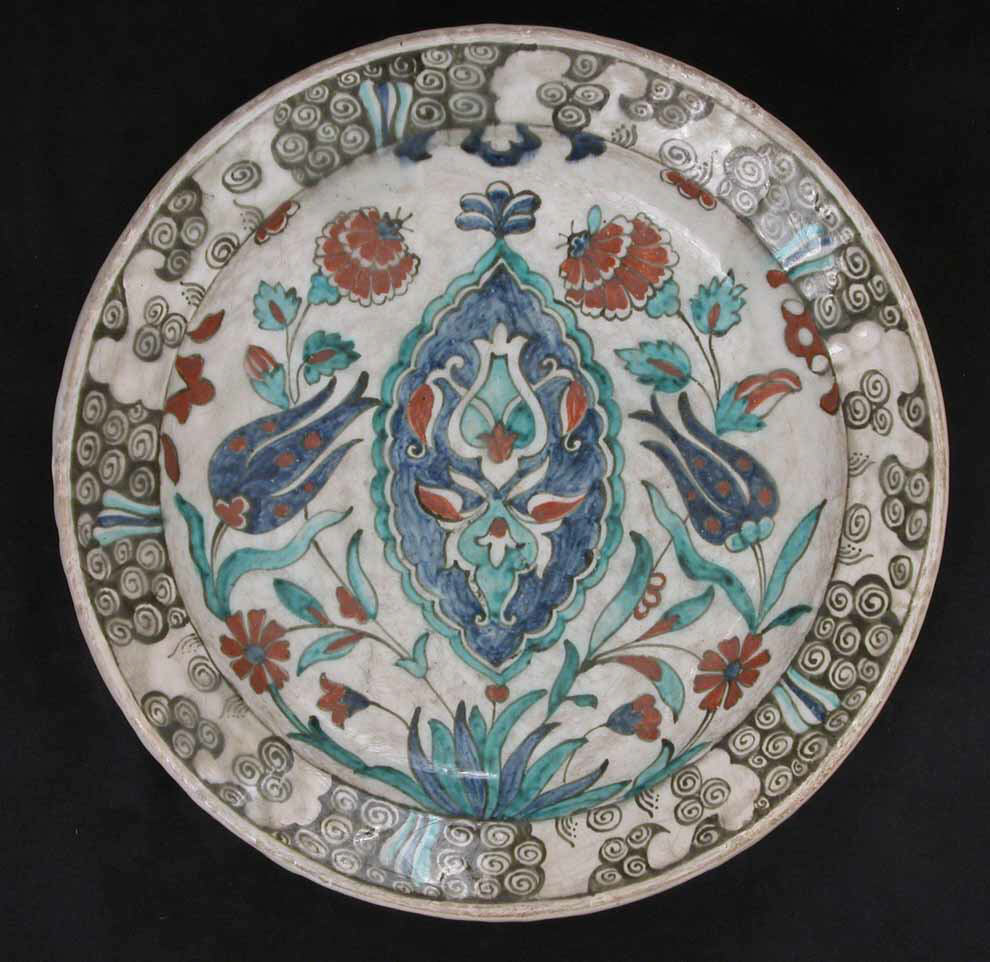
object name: dish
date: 1567-1633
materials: stonepaste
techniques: glazing, painting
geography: turkey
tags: flowers,leaves